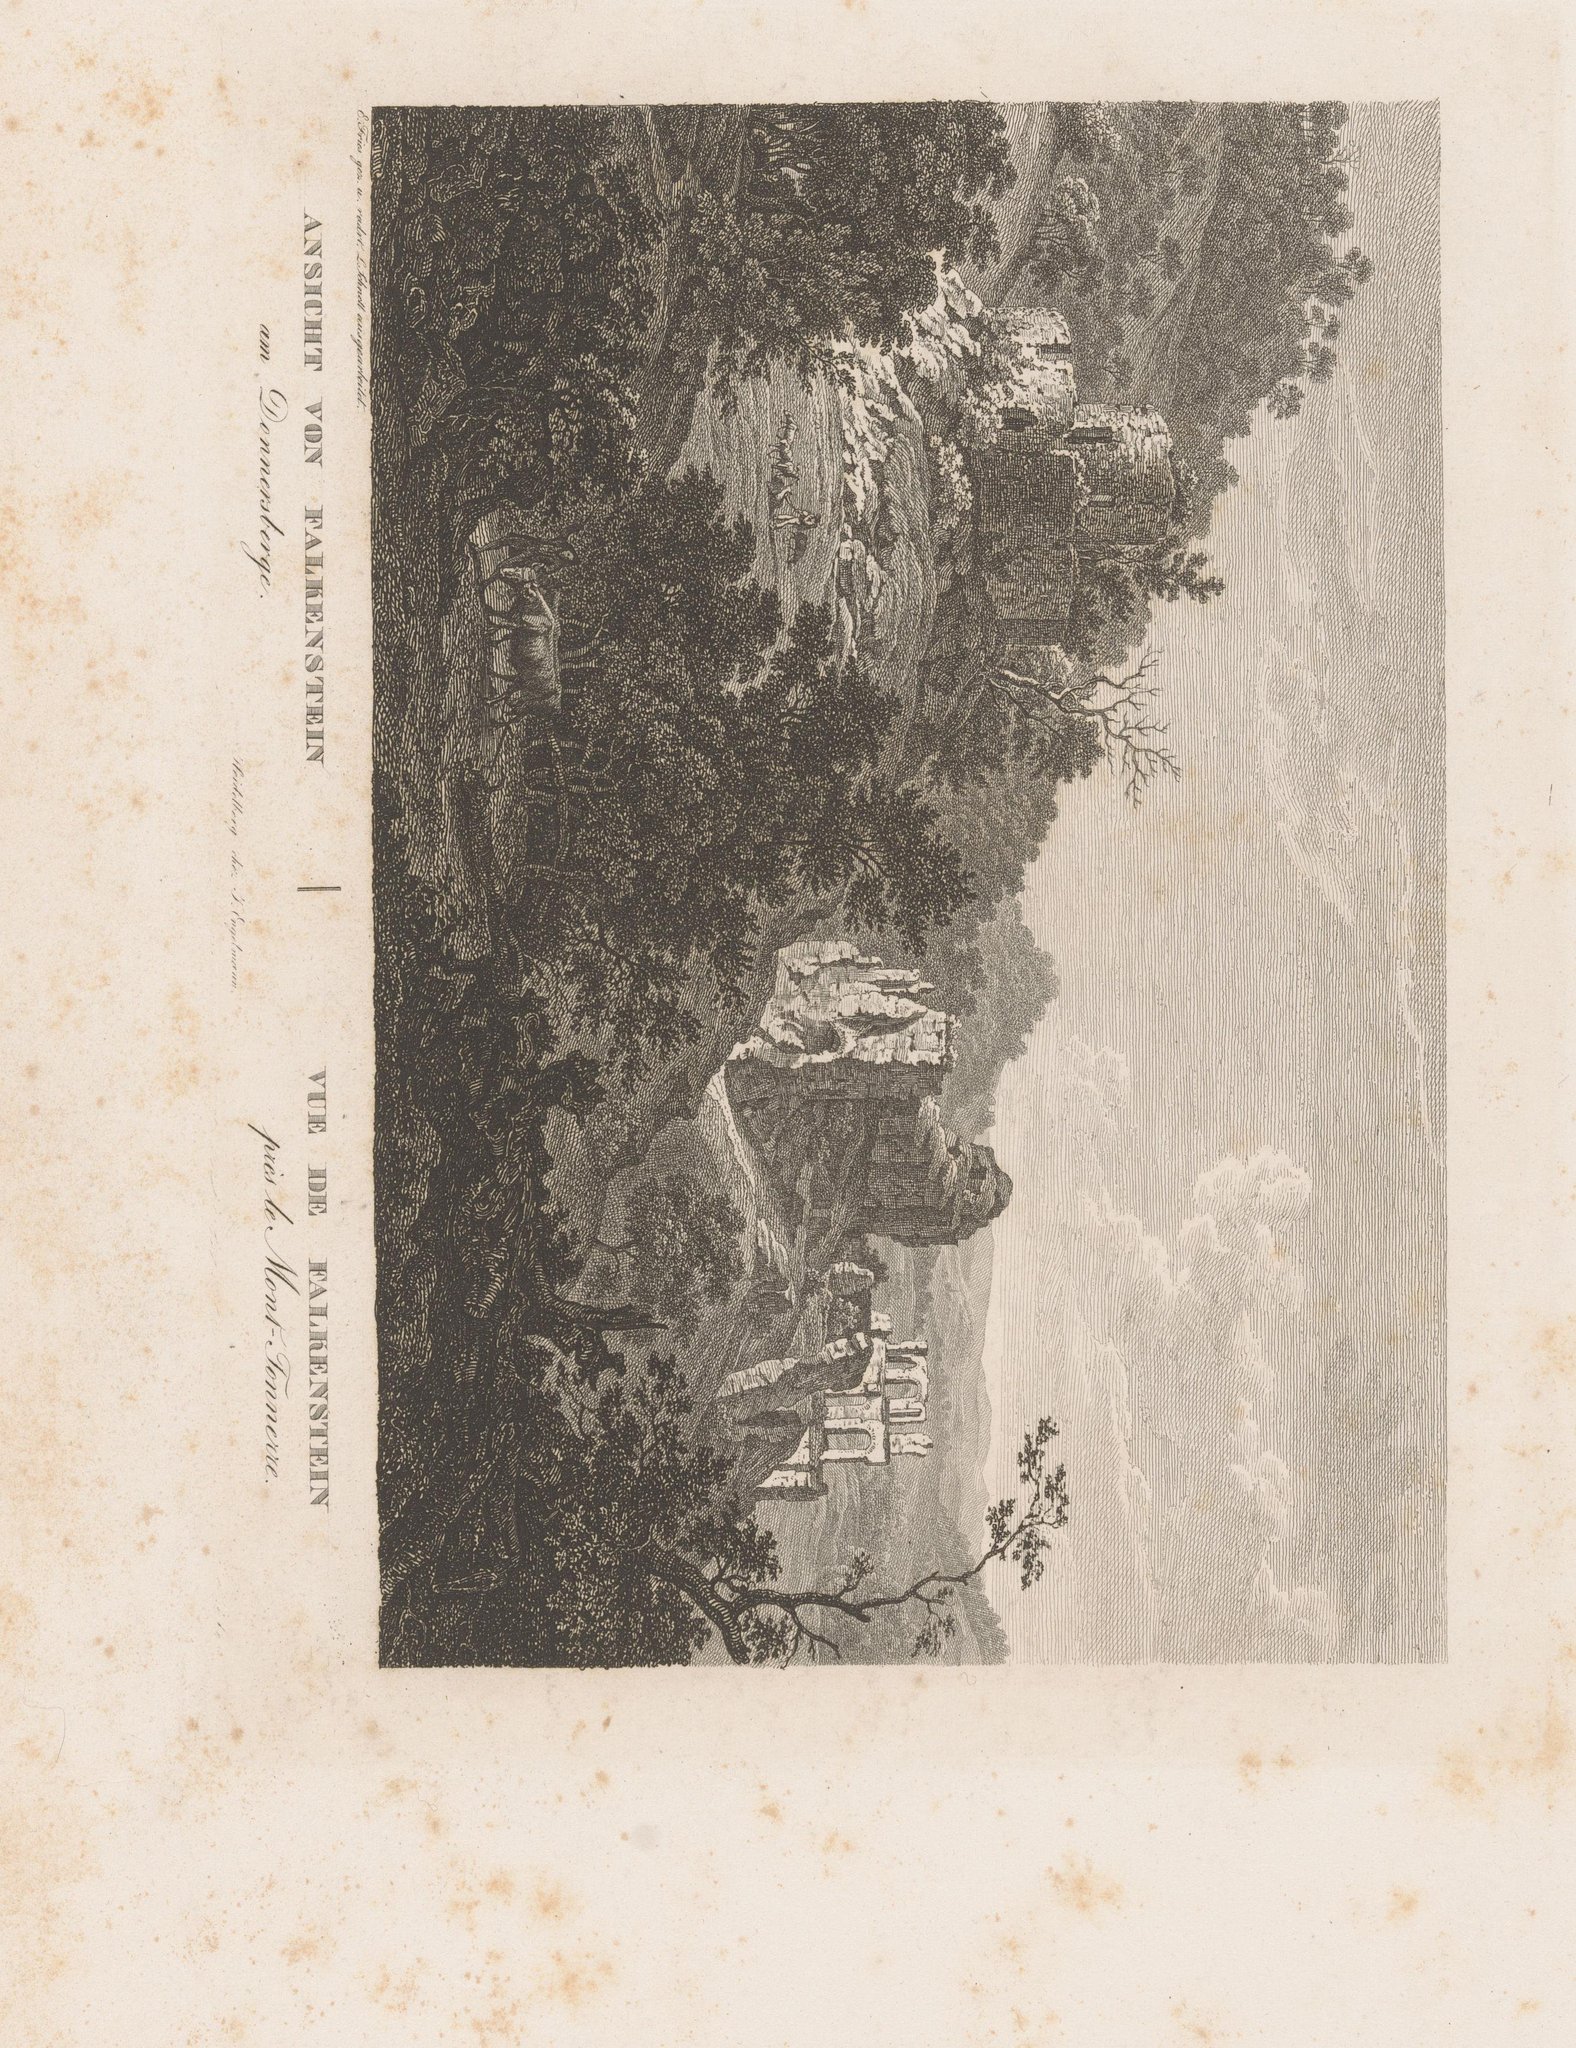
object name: print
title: Gezicht op Falkenstein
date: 1811-1833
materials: paper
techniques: etching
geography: heidelberg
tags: herding, herdsman, herdswoman, shepherd, shepherdess, cowherd, etc., landscape with ruins, ploughing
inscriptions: collector's mark: Lugt 2228